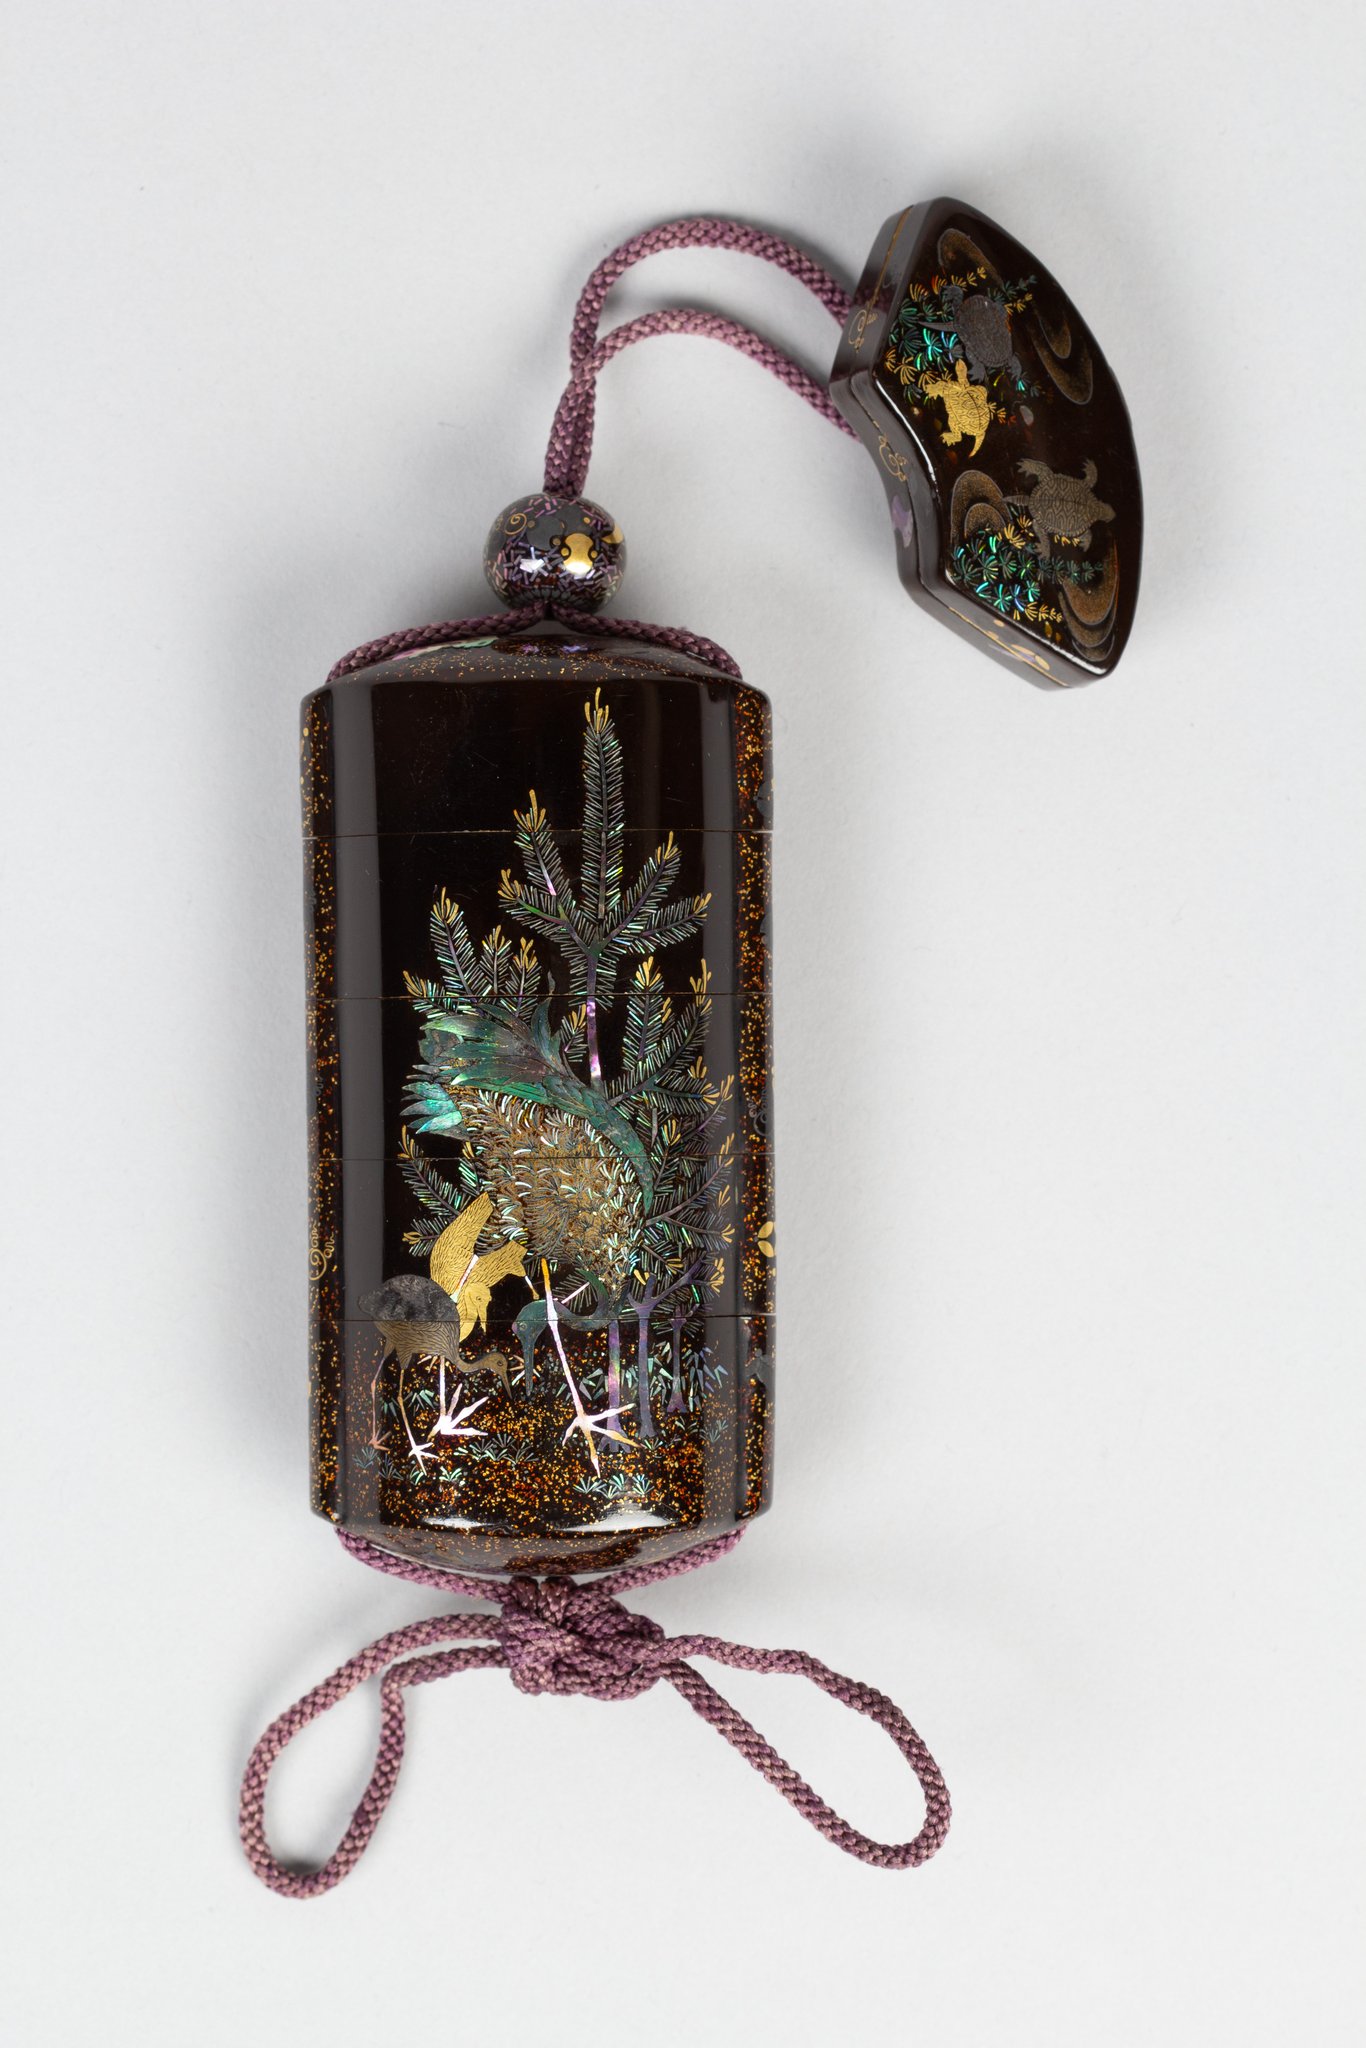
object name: inrō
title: Case (Inrō) with Design of Cranes and Pines with Takaramono (Mythical Treasure)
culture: japanese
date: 1801-1900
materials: gold foil, lacquer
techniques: fundame, hiramakie, inlay, roiro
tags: cranes,trees